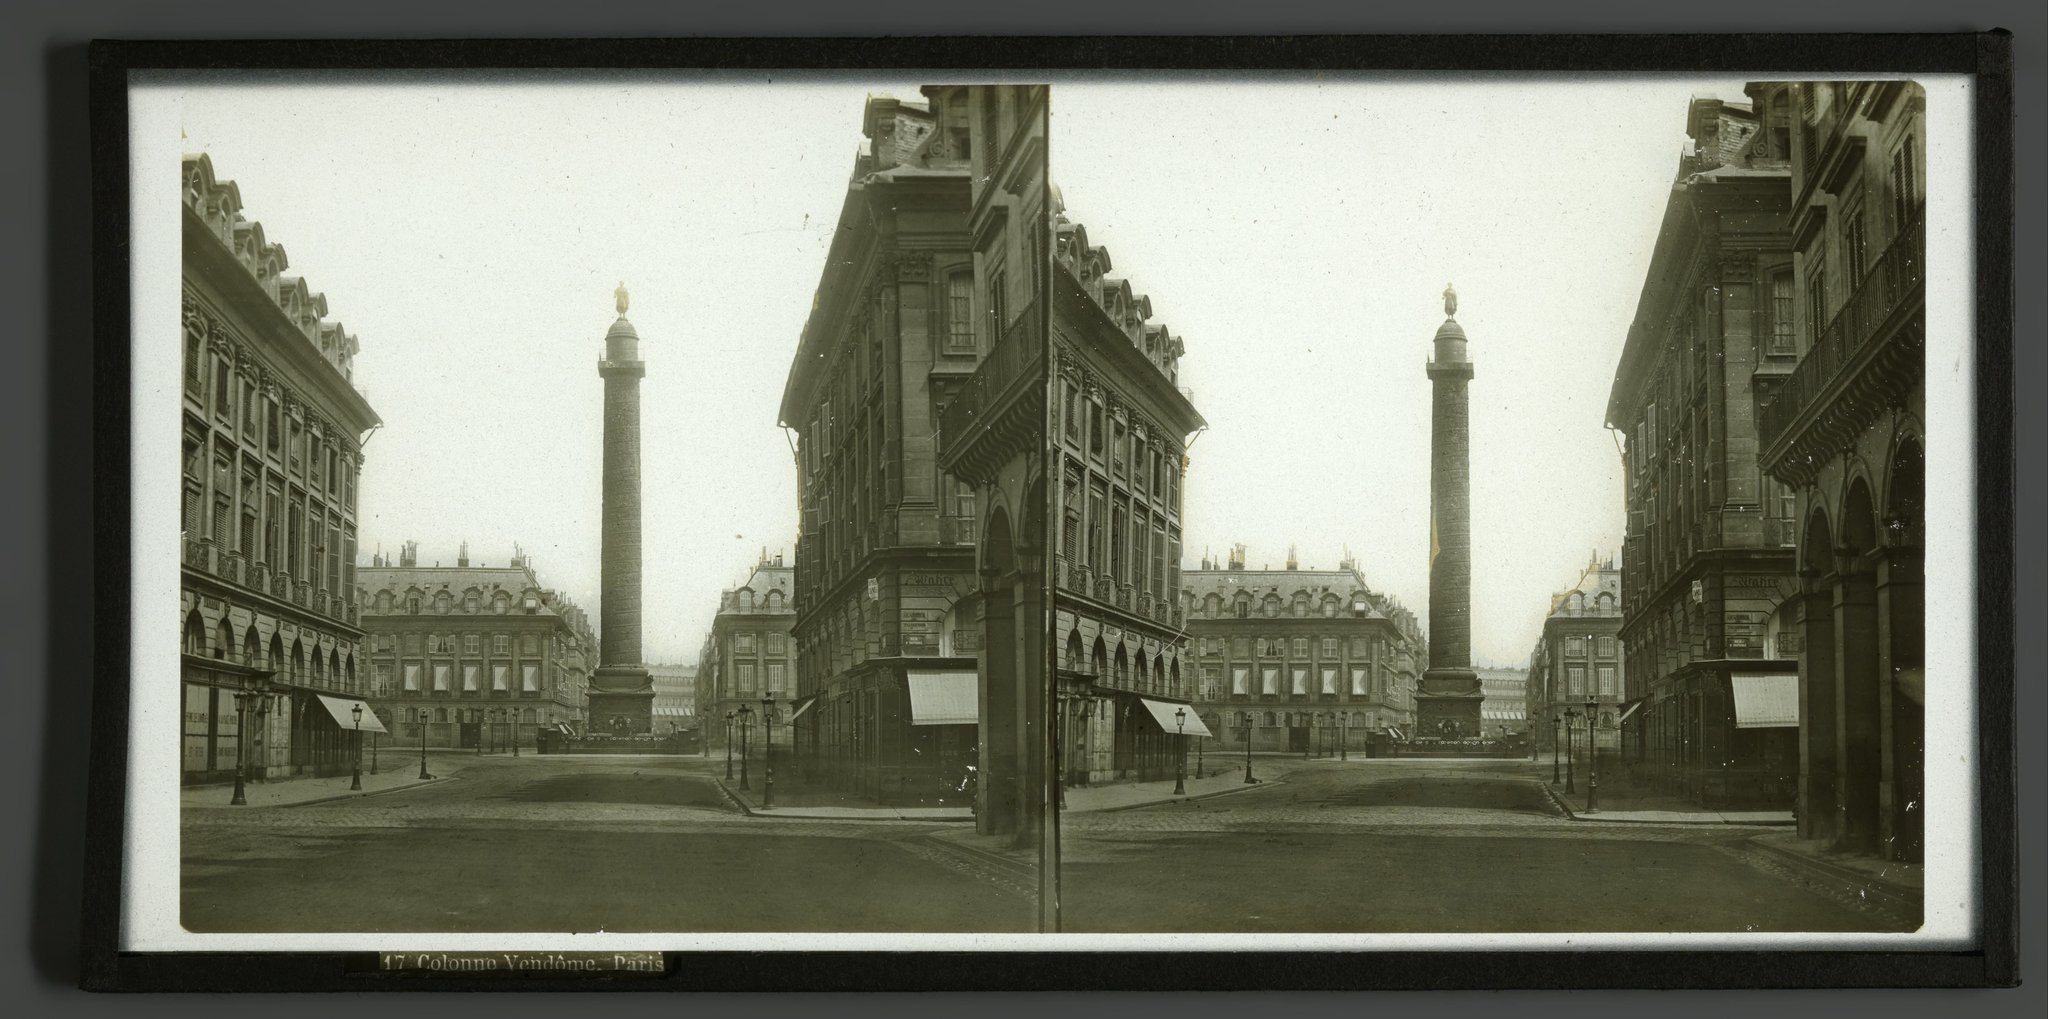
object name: stereoscopic photograph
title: Gezicht op de Colonne Vendôme op Place Vendôme in Parijs, Frankrijk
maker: Anonymous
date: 1856-1890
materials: glass, paper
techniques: slide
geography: paris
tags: square, place, circus, etc., triumphal column with helical friezes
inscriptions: number: ‘17’